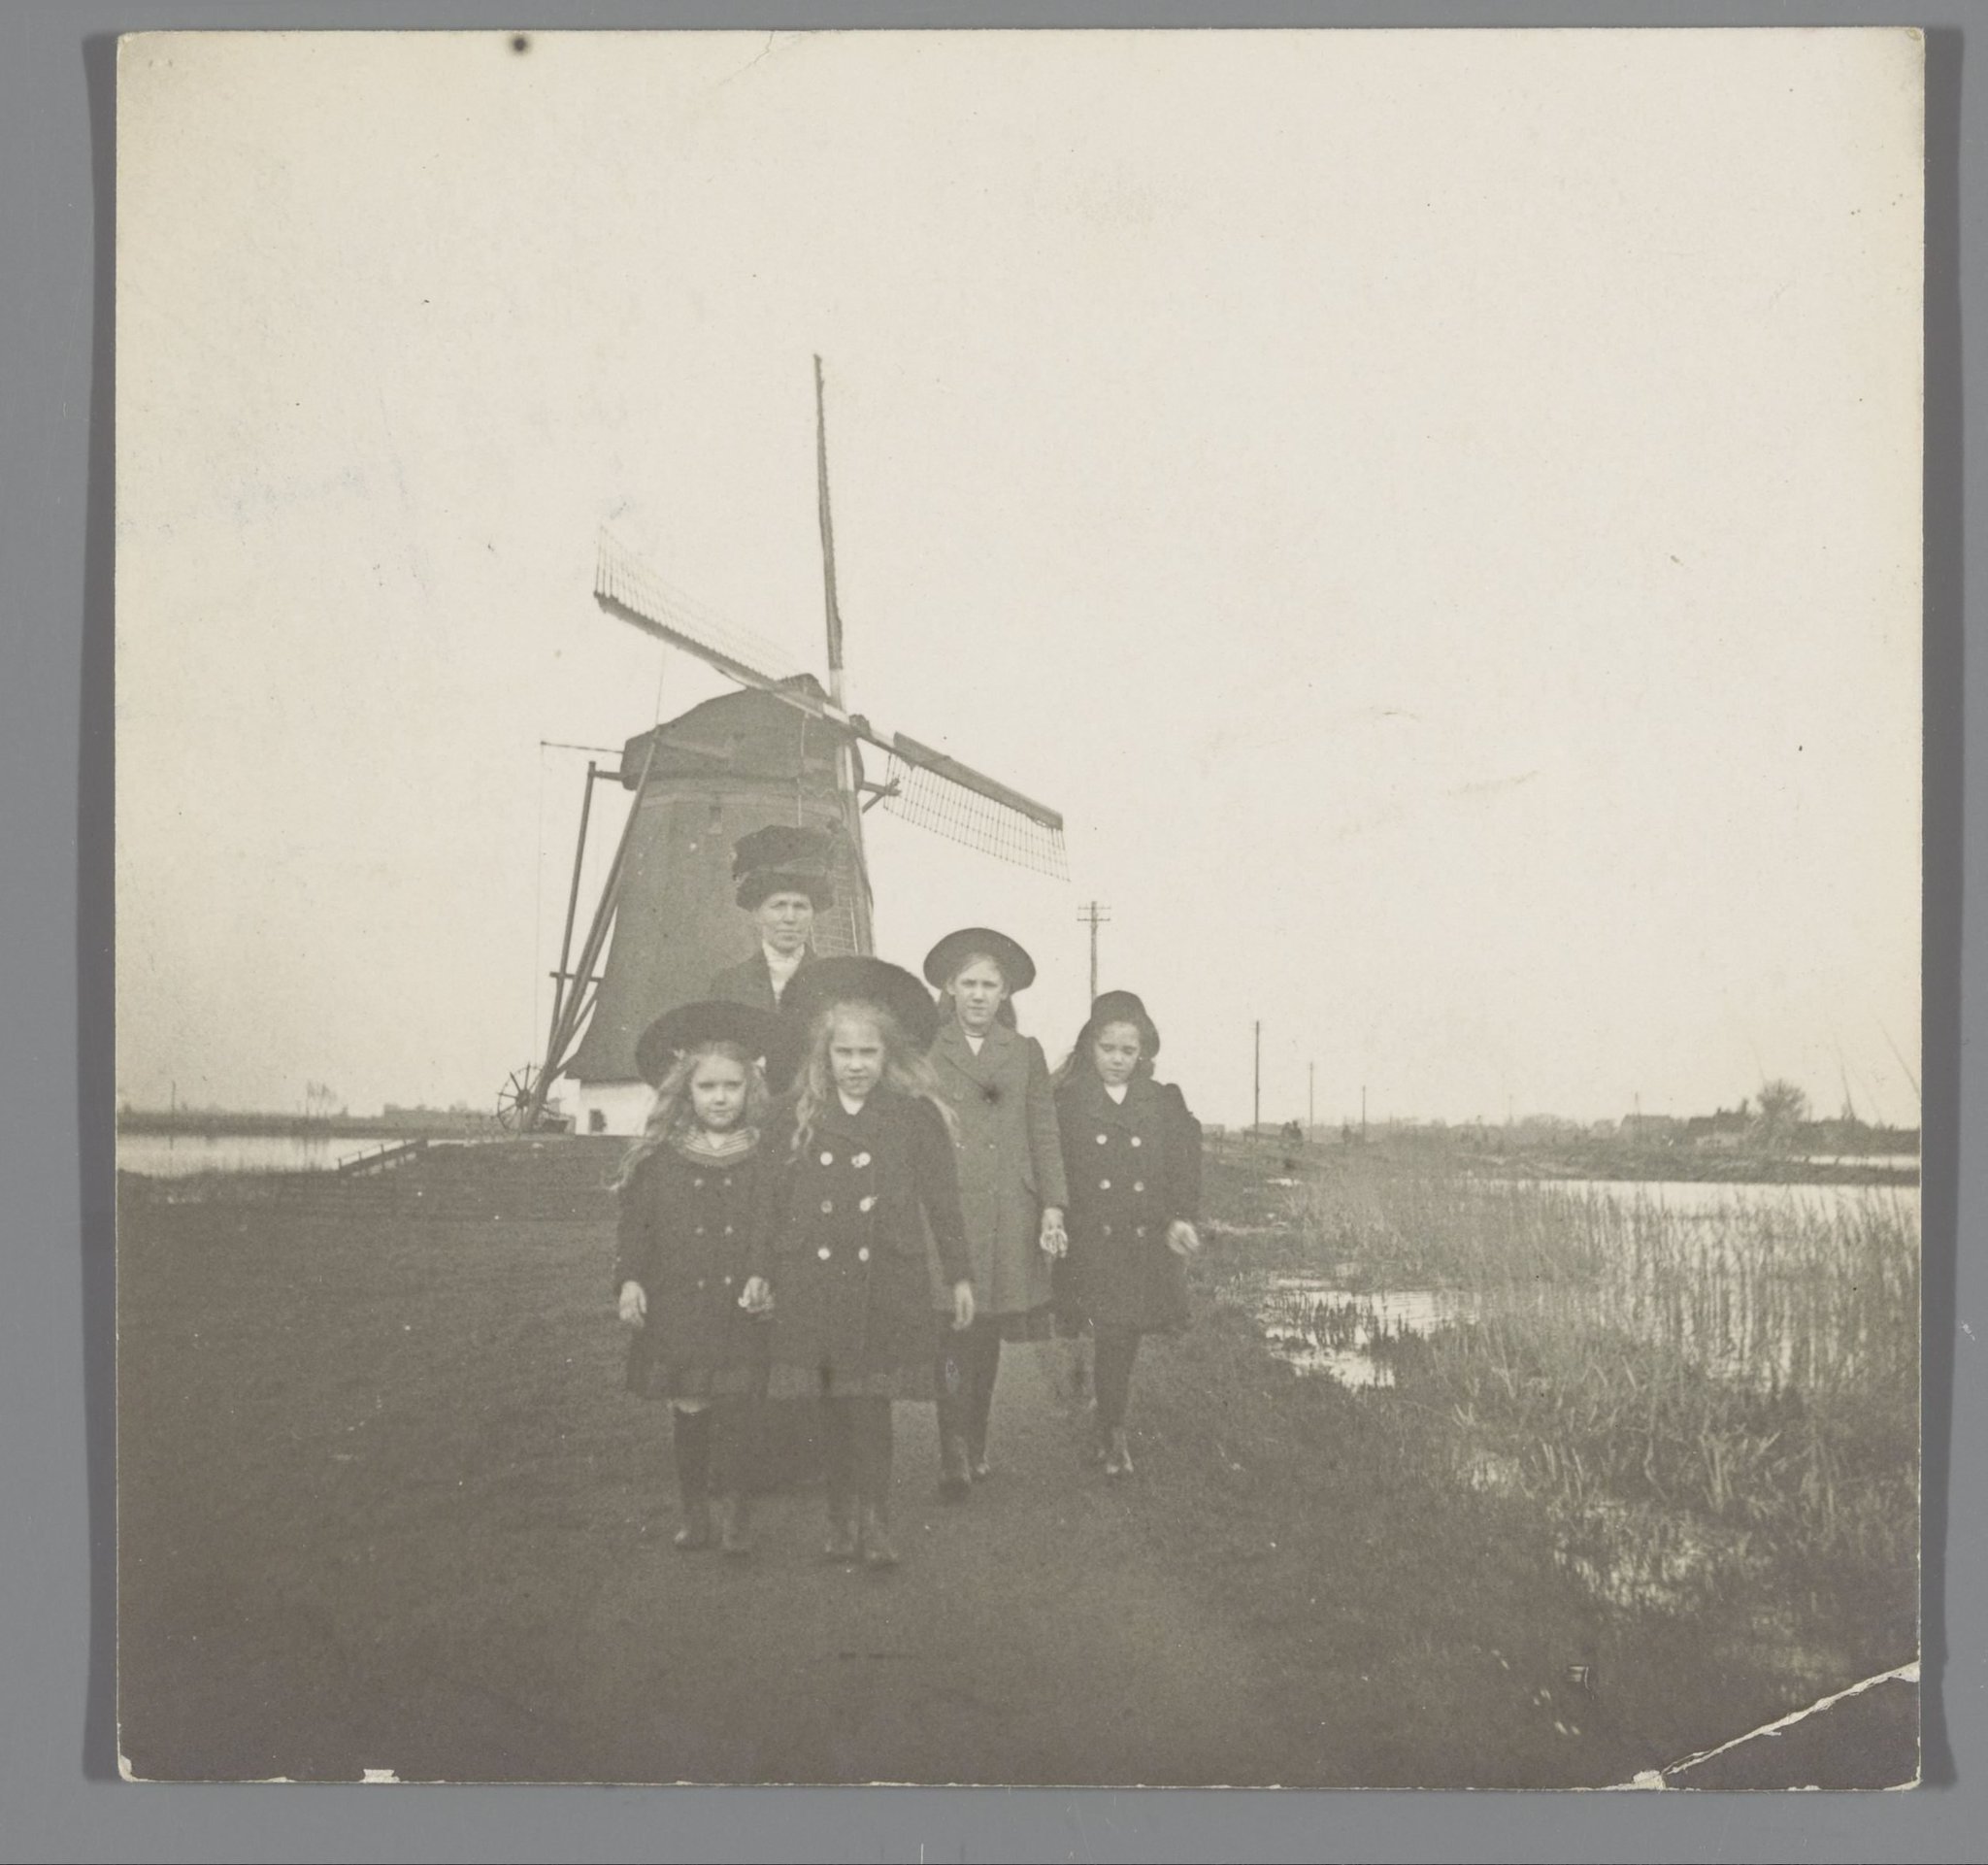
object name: photograph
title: Moeder met vier meisjes in een polder langs de Rotte, achter hen een windmolen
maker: Anonymous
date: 1905-1910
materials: paper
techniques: gelatin silver print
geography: netherlands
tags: river, windmill in landscape, family life